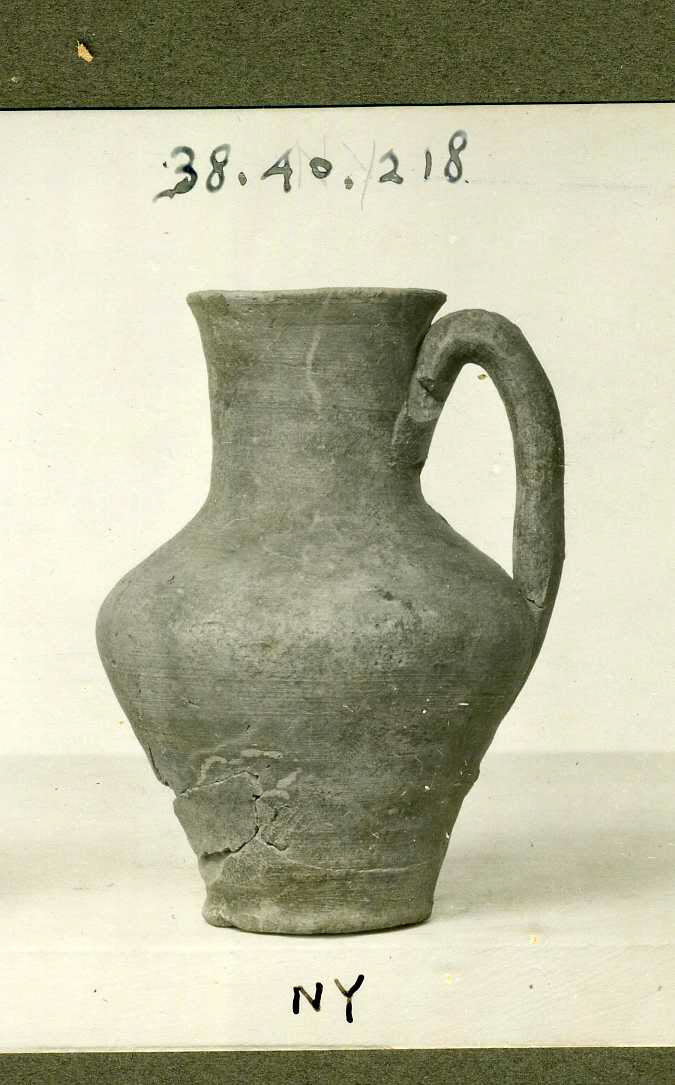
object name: ewer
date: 767-1000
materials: earthenware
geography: iran